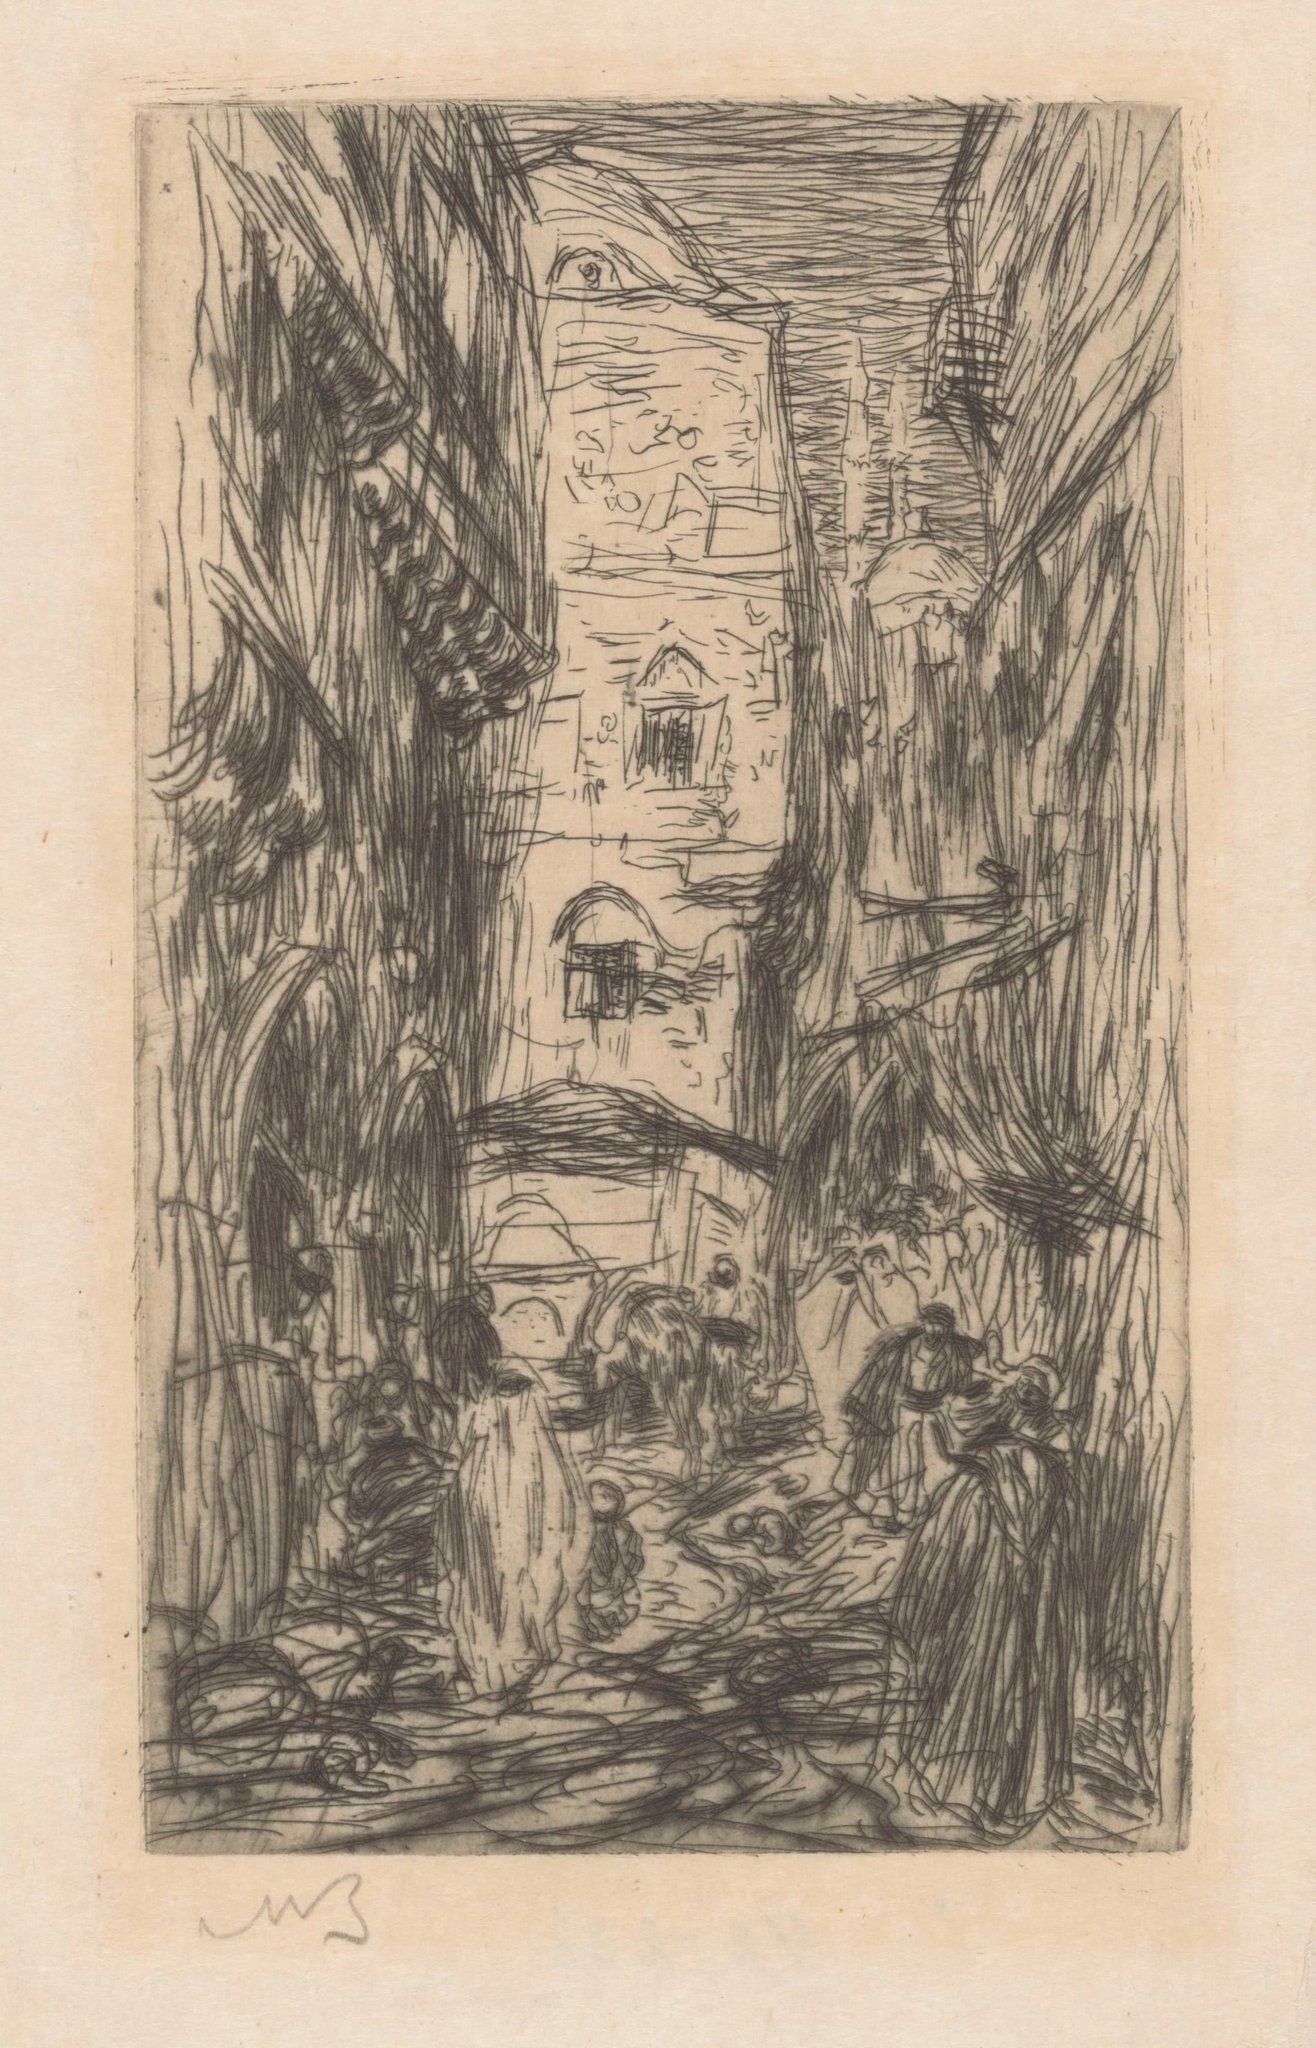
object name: print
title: Straat in Constantinopel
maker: marius bauer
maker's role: draughtsman, print maker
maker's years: 1867-1932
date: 1888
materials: paper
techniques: etching, intaglio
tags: temple, shrine ~ islam, mohammedanism, street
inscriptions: collector's mark: Lugt 2228, collector's mark: Lugt 2760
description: Een straat met mensen in oosterse kleding. Rechts op de achtergrond twee minaretten van een moskee.